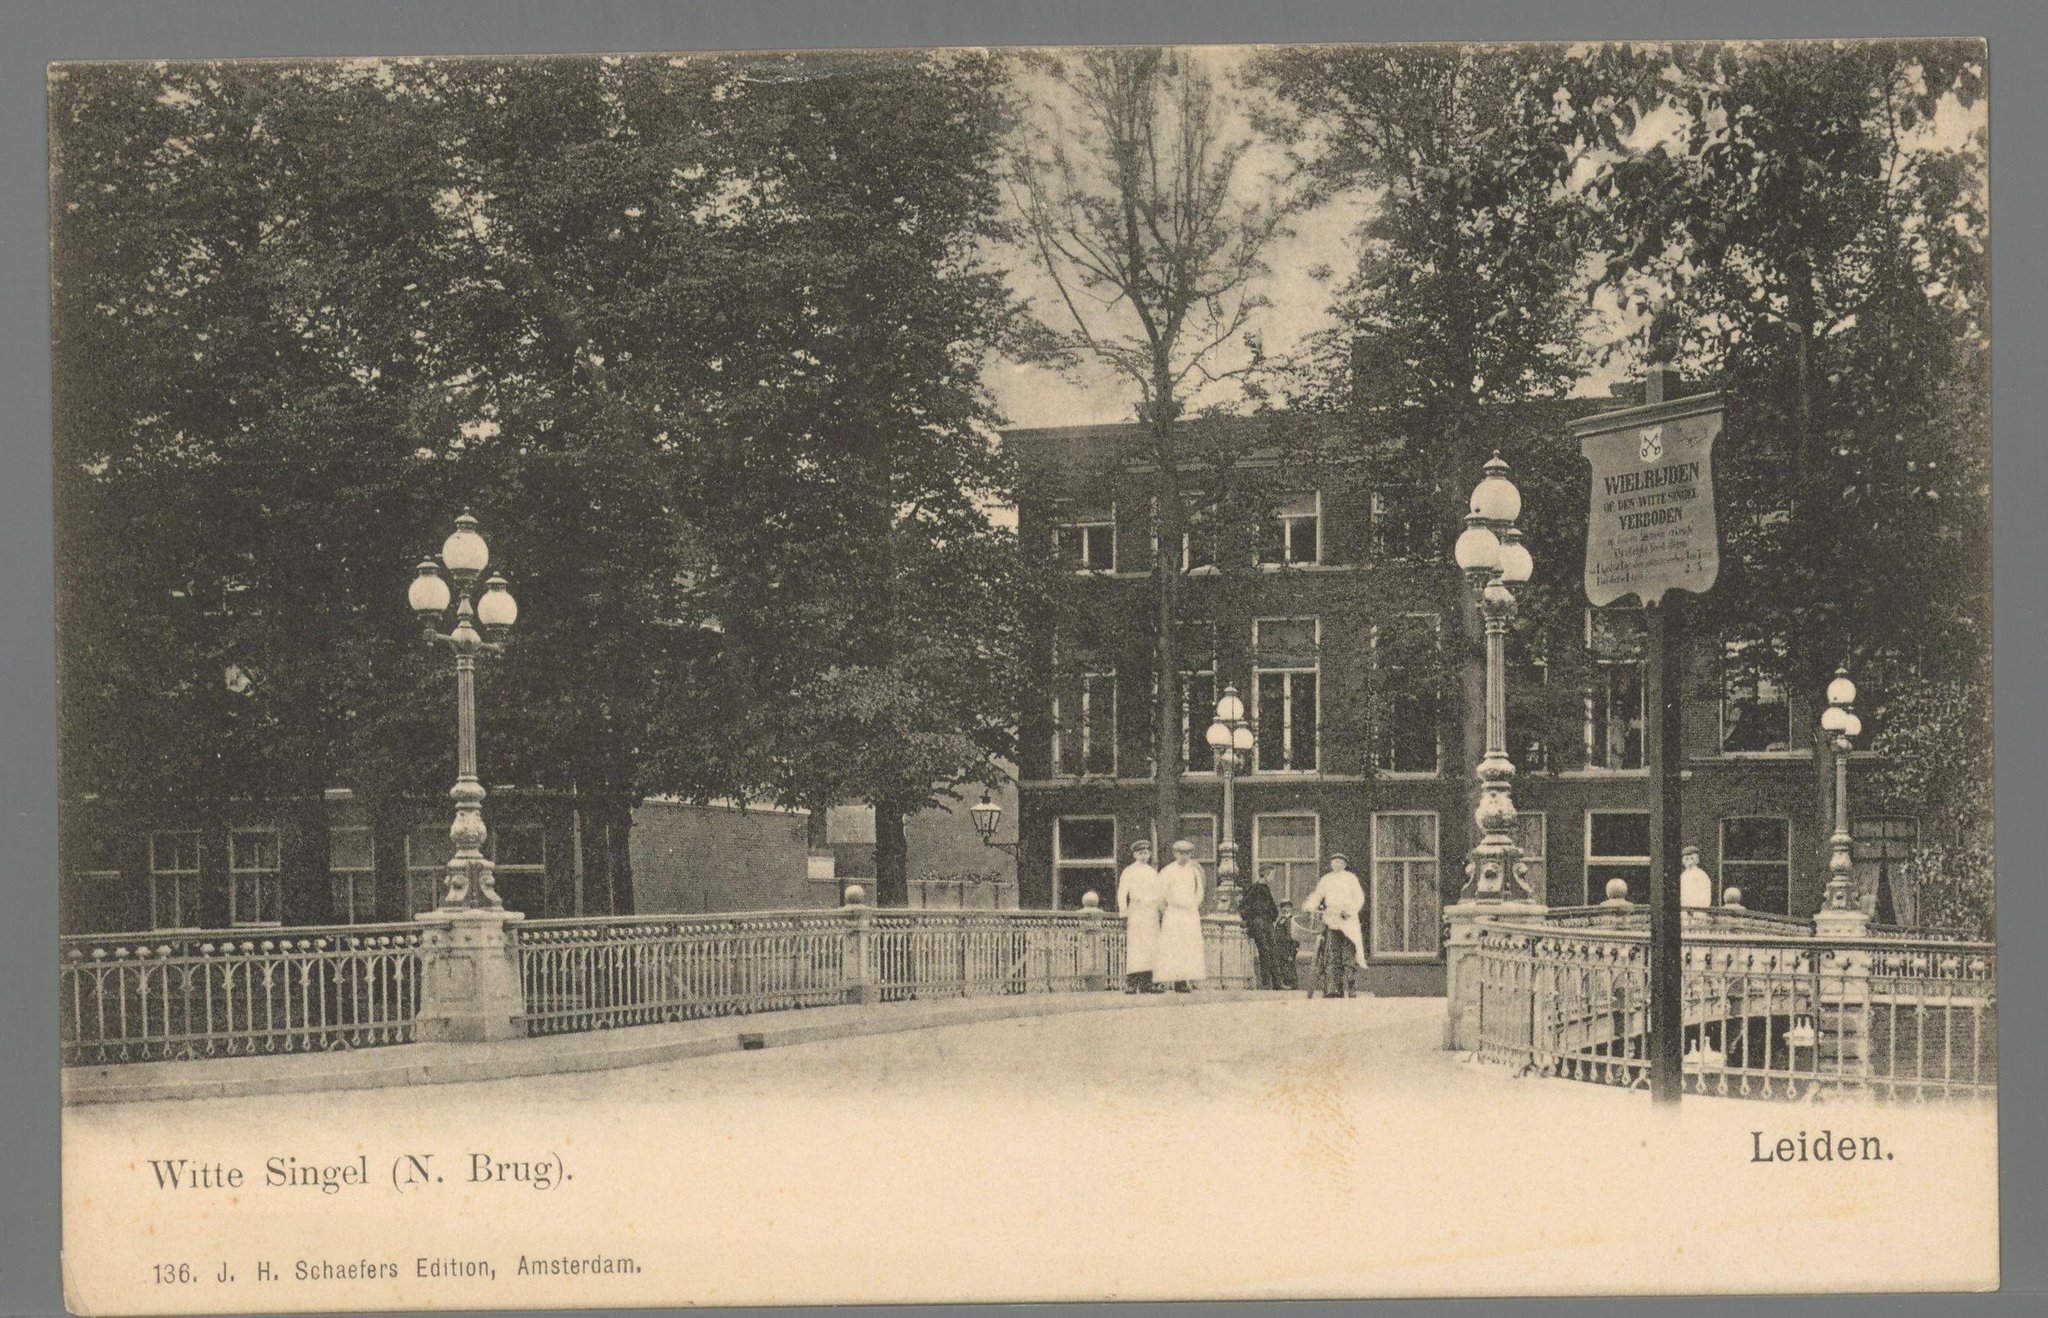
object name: ansichtkaart, prentbriefkaart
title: Witte Singel (N. Brug). Leiden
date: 1897-1905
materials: cardboard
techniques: photograph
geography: amsterdam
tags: bridge in city across river, canal, etc.